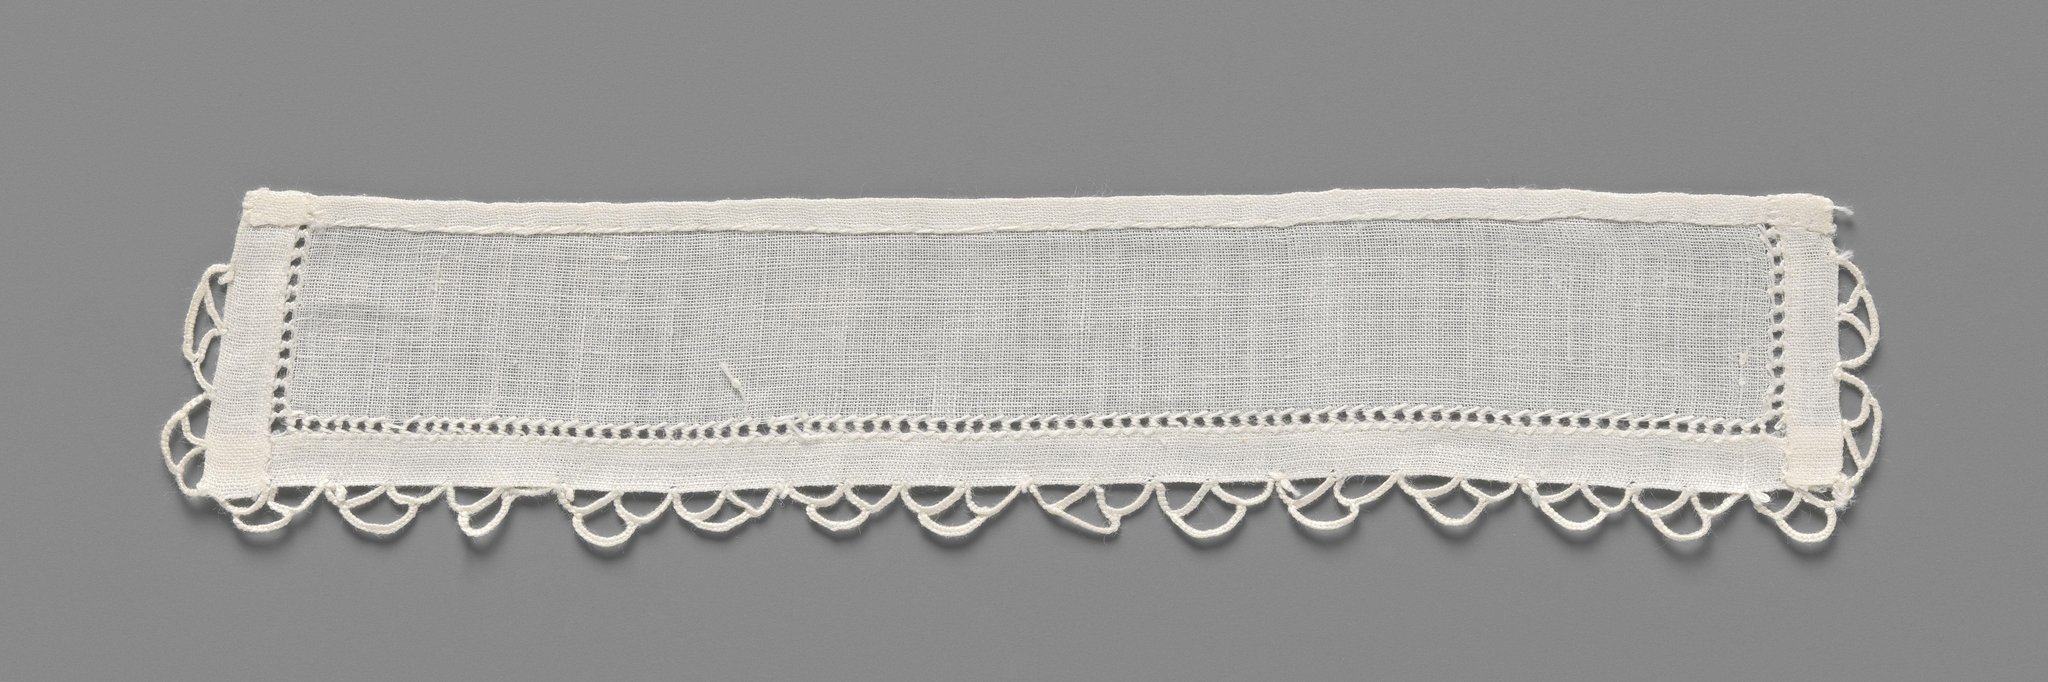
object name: cuff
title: Manchet van linnen batist langs drie kanten afgewerkt met open zomen en een boogjesrand van gehaakte kant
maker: Anonymous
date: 1900-1910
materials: textile, linen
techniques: weave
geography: amsterdam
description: Manchet van naturelkleurig batist langs drie kanten afgewerkt met een smal randje open naaiwerk langs de zomen: werk met uitgetrokken draden. Langs één lange en twee korte zijden is een schulpenrandje gemaakt met boogjes: gehaakte kant.